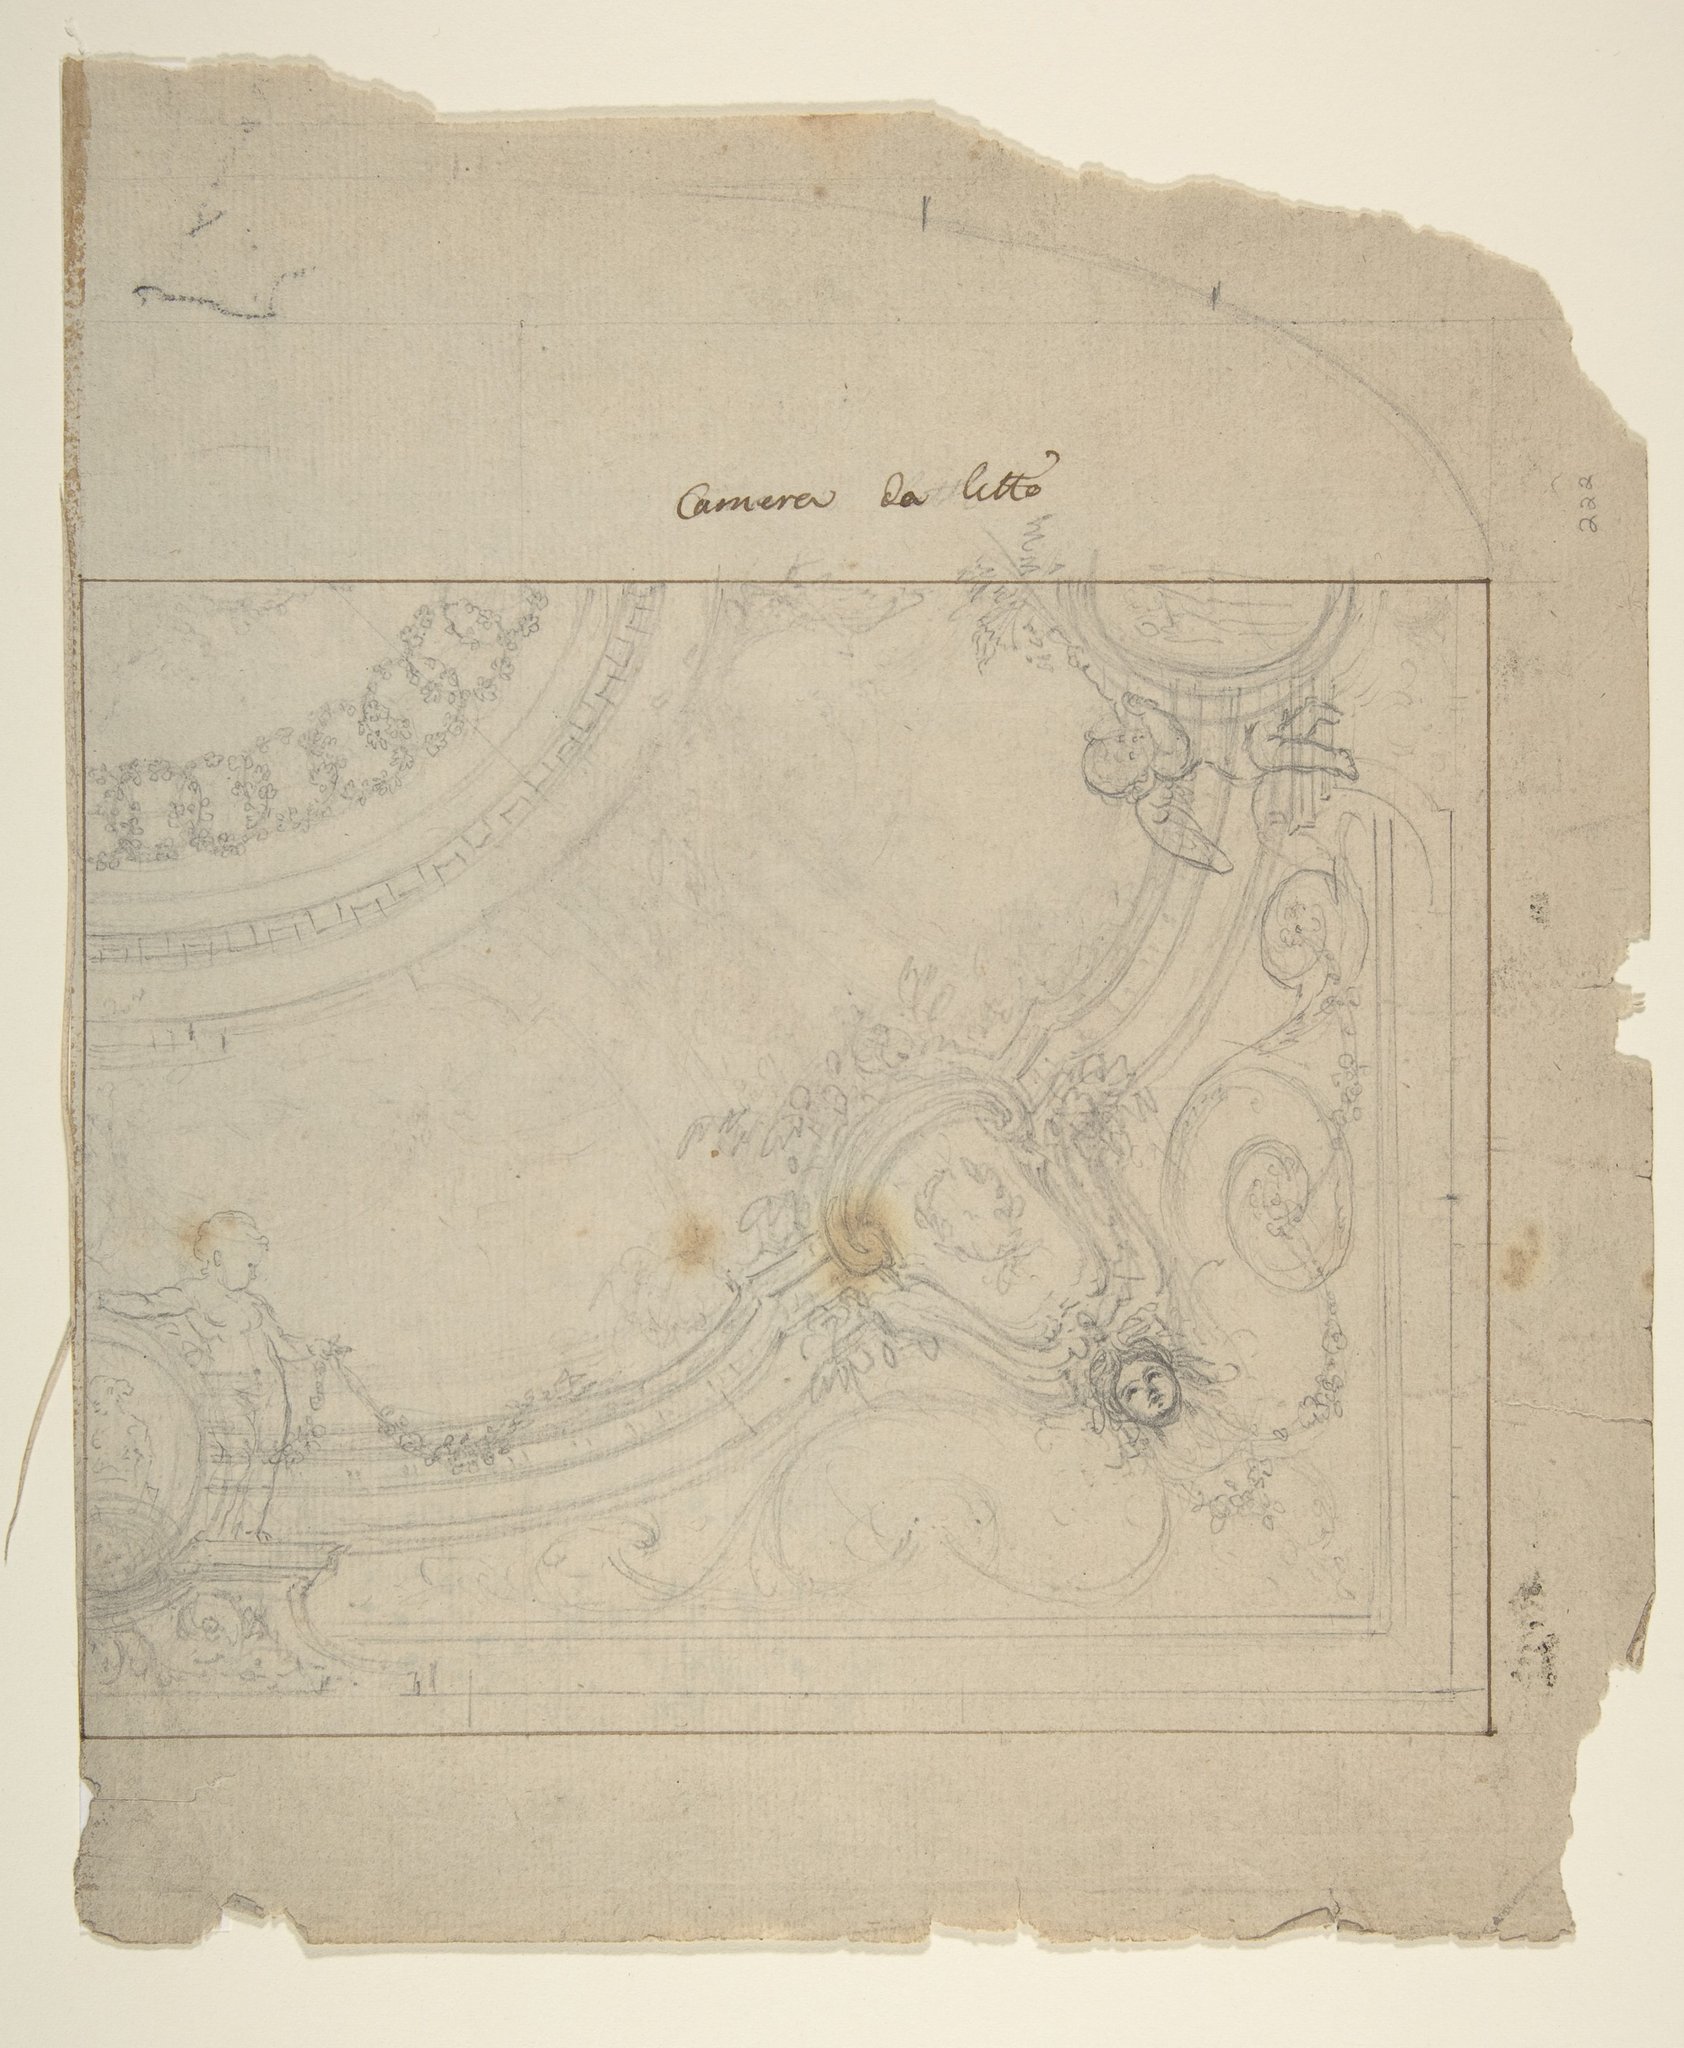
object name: drawing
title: Ceiling Design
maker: leonardo marini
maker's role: artist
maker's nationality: italian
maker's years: 1730-1797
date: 1701-1800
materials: graphite, ink, drawing material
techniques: pen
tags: ceilings